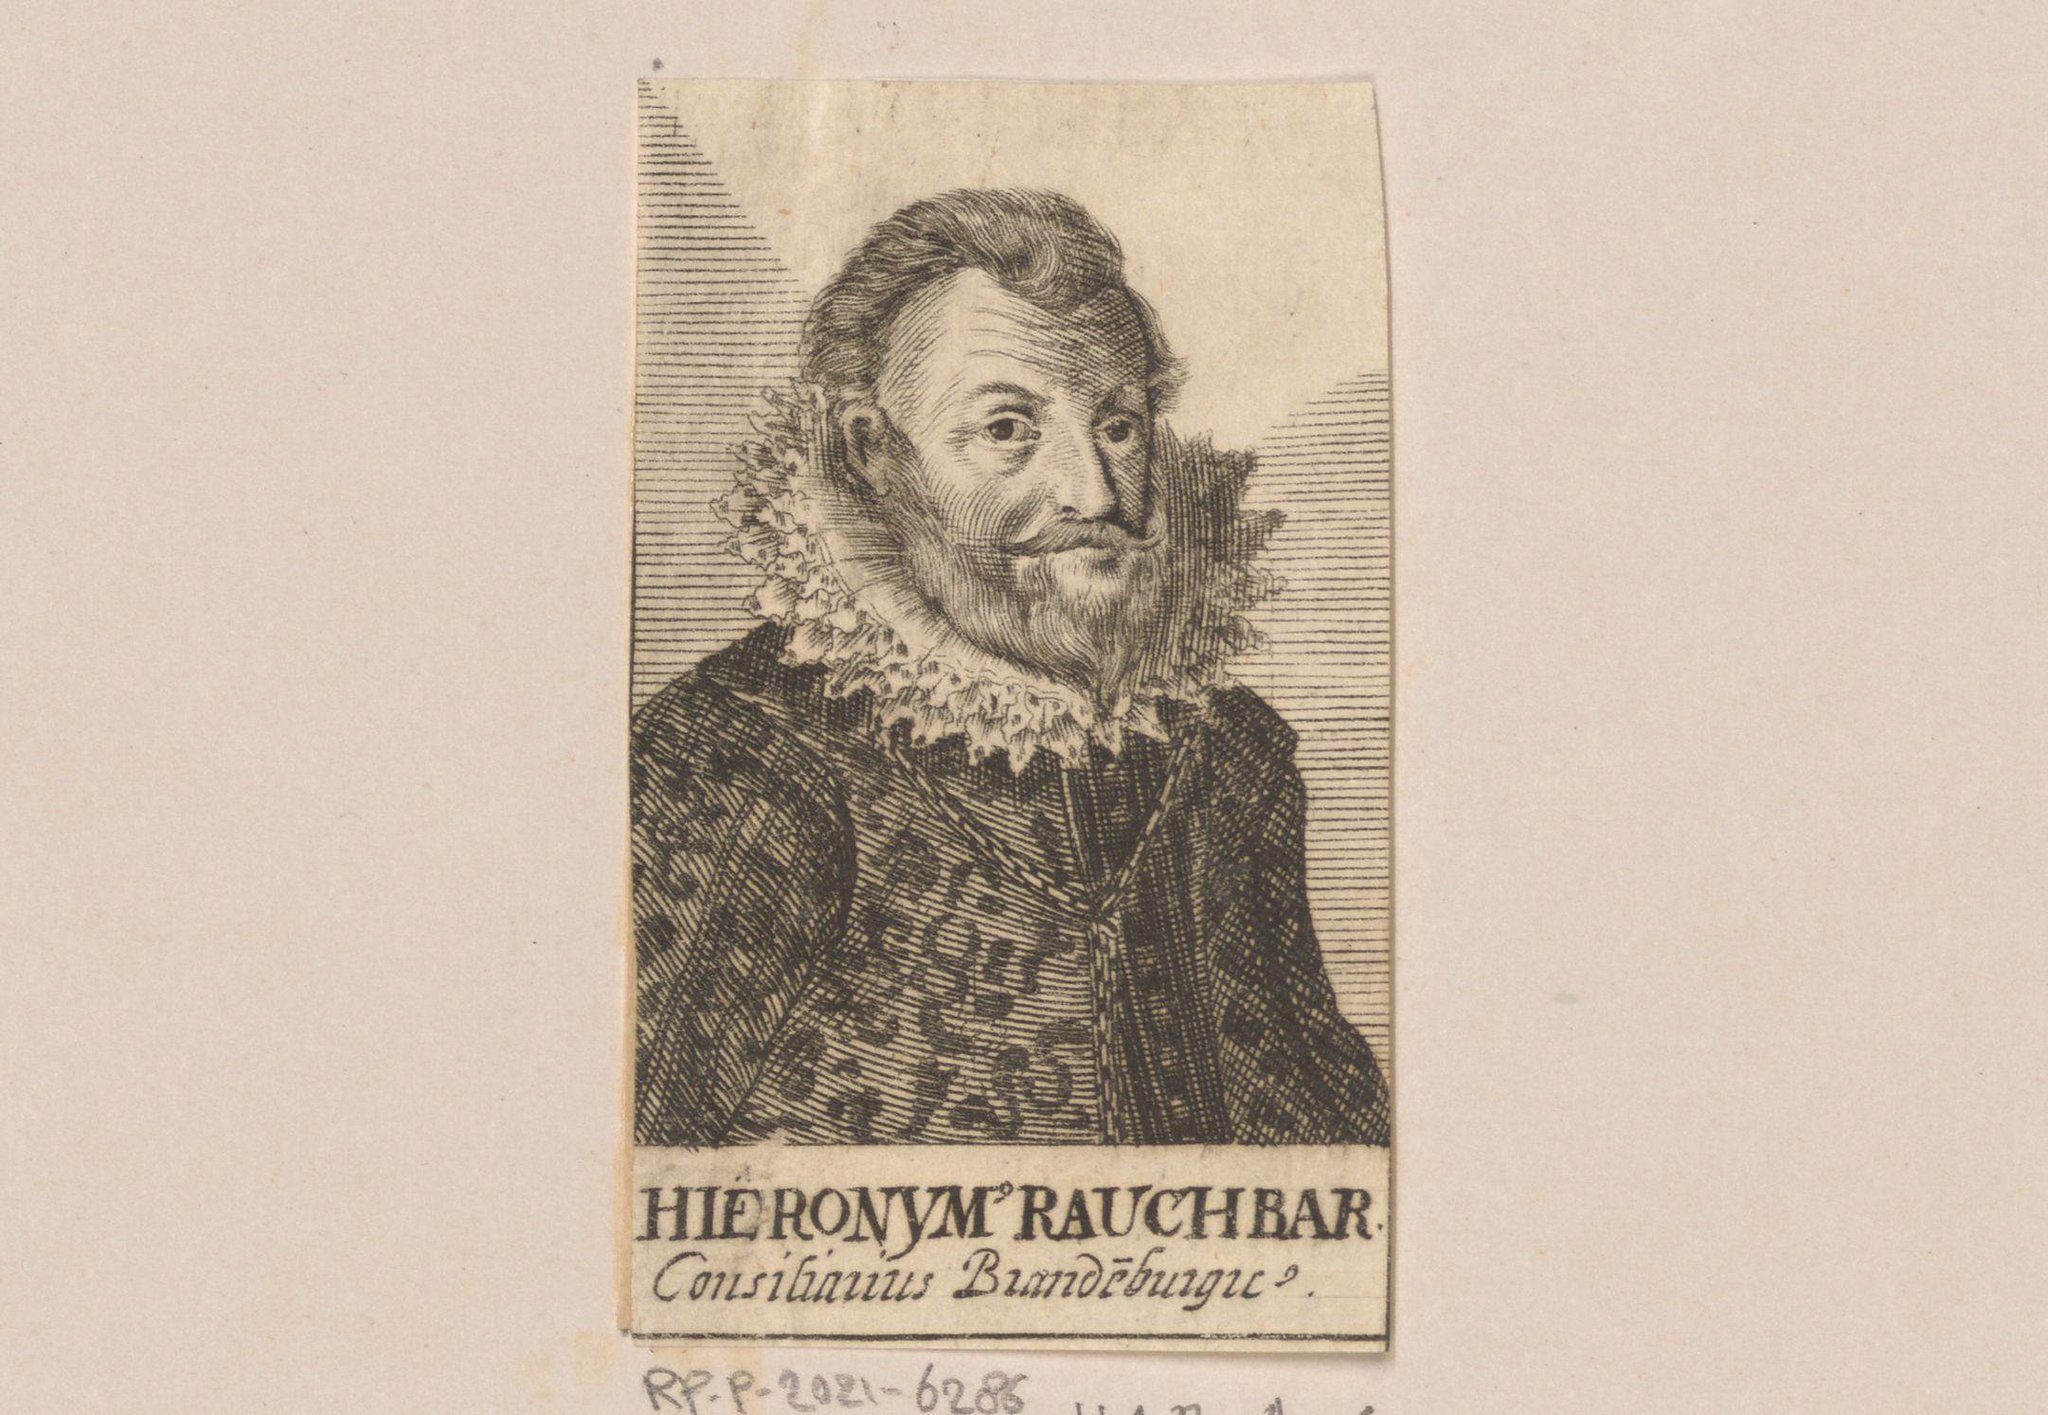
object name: print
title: Portret van Hieronymus Rauchbar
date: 1688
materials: paper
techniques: engraving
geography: nuremberg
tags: historical persons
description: Prent mogelijk uit: Freher, Paul. Theatrum virorum eruditione clarorum. Neurenberg: Johann Hoffmann, 1688.